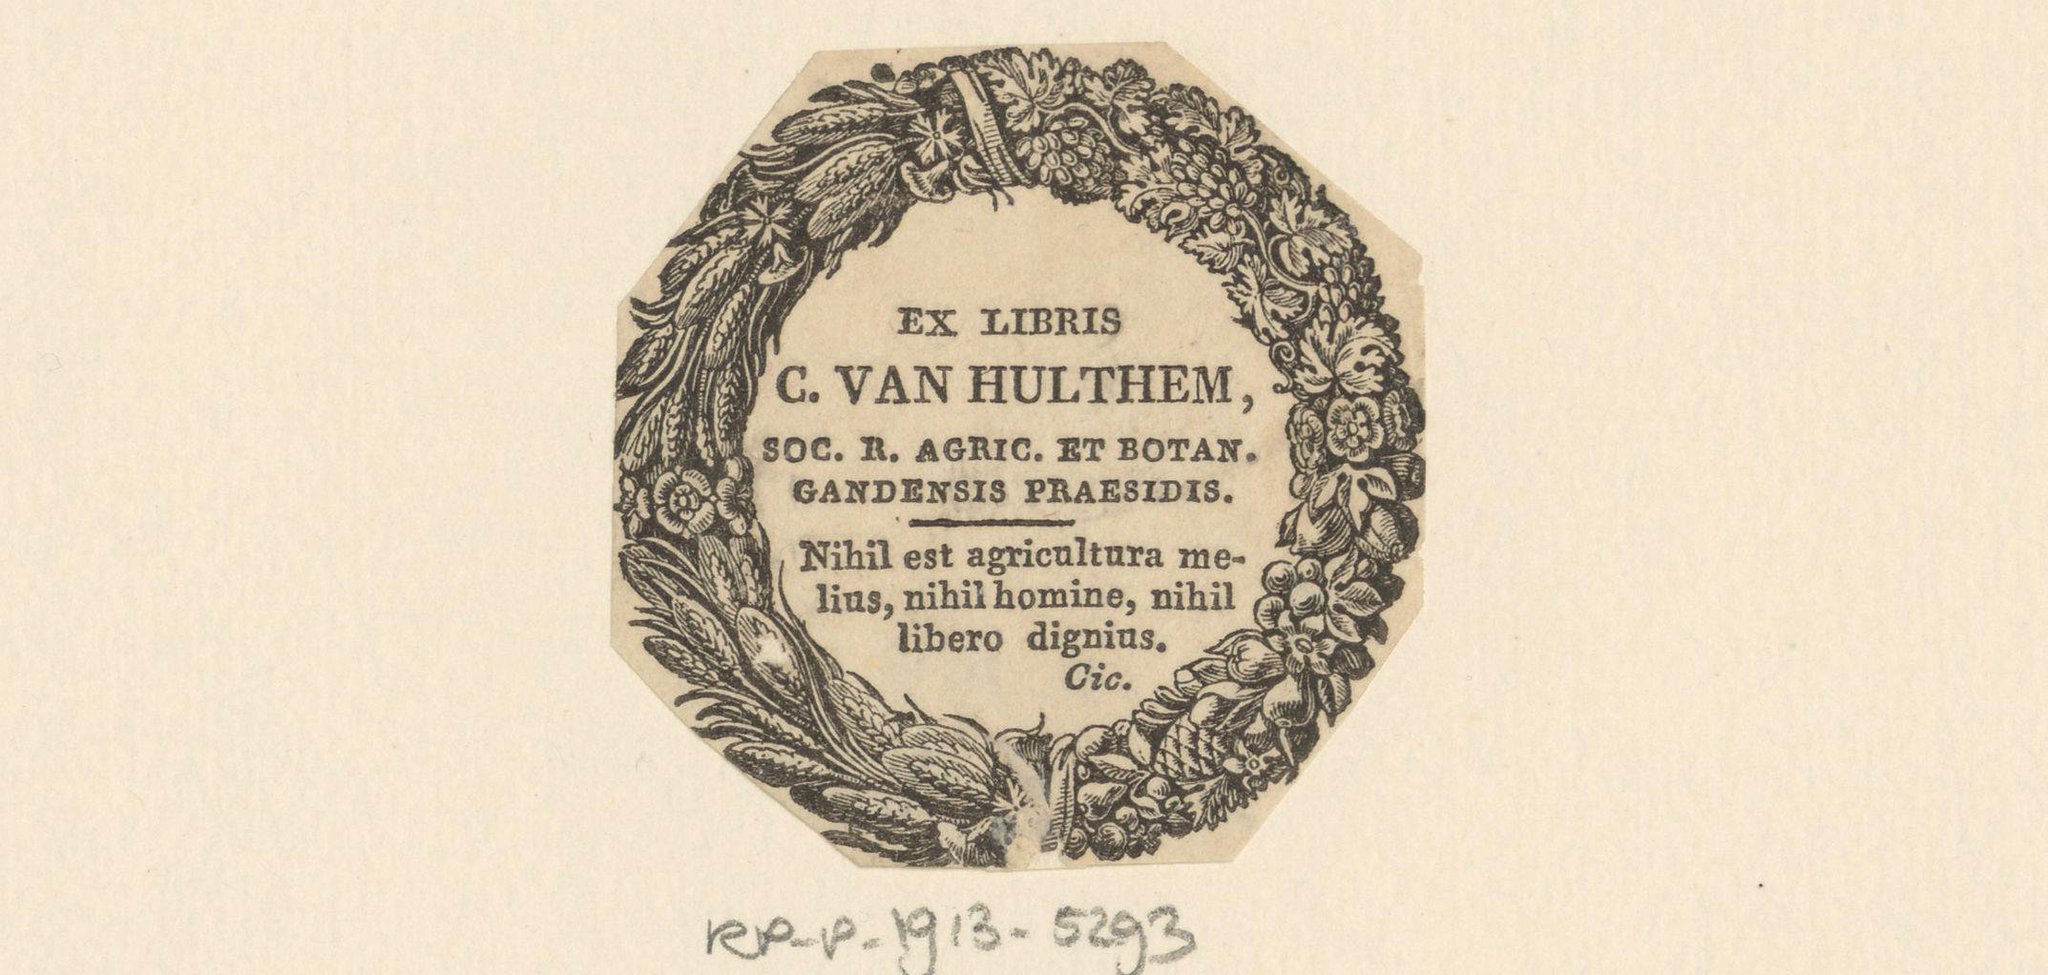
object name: bookplate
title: Nihil est agricultura (...) nihil libero dignius.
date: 1774-1832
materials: paper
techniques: letterpress printing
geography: belgium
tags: ghent, politician, cut flowers; nosegay, bunch of flowers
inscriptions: collector's mark: Lugt 2760, collector's mark: Lugt 2233